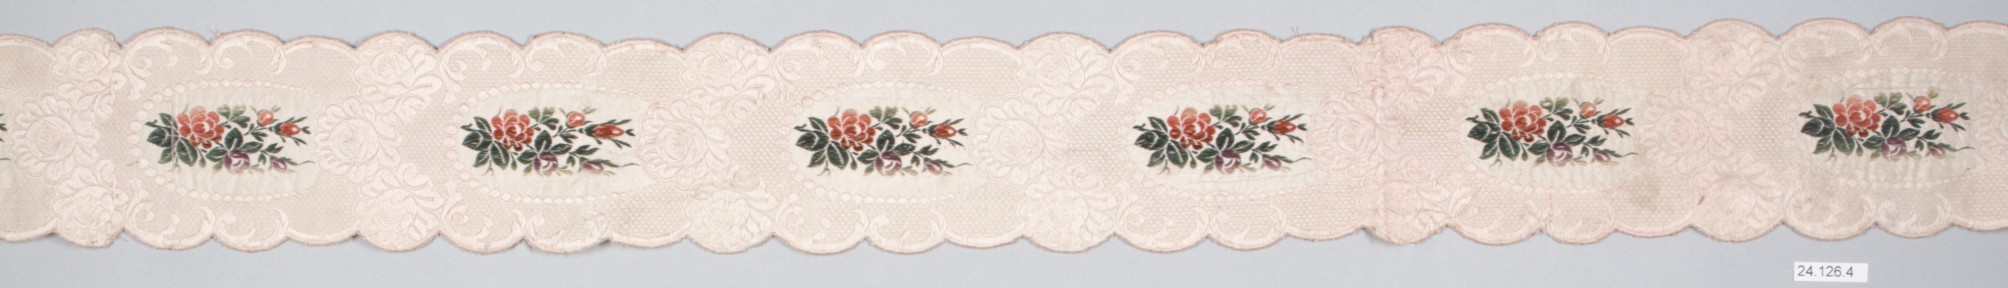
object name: ribbon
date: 1801-1900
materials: silk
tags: flowers